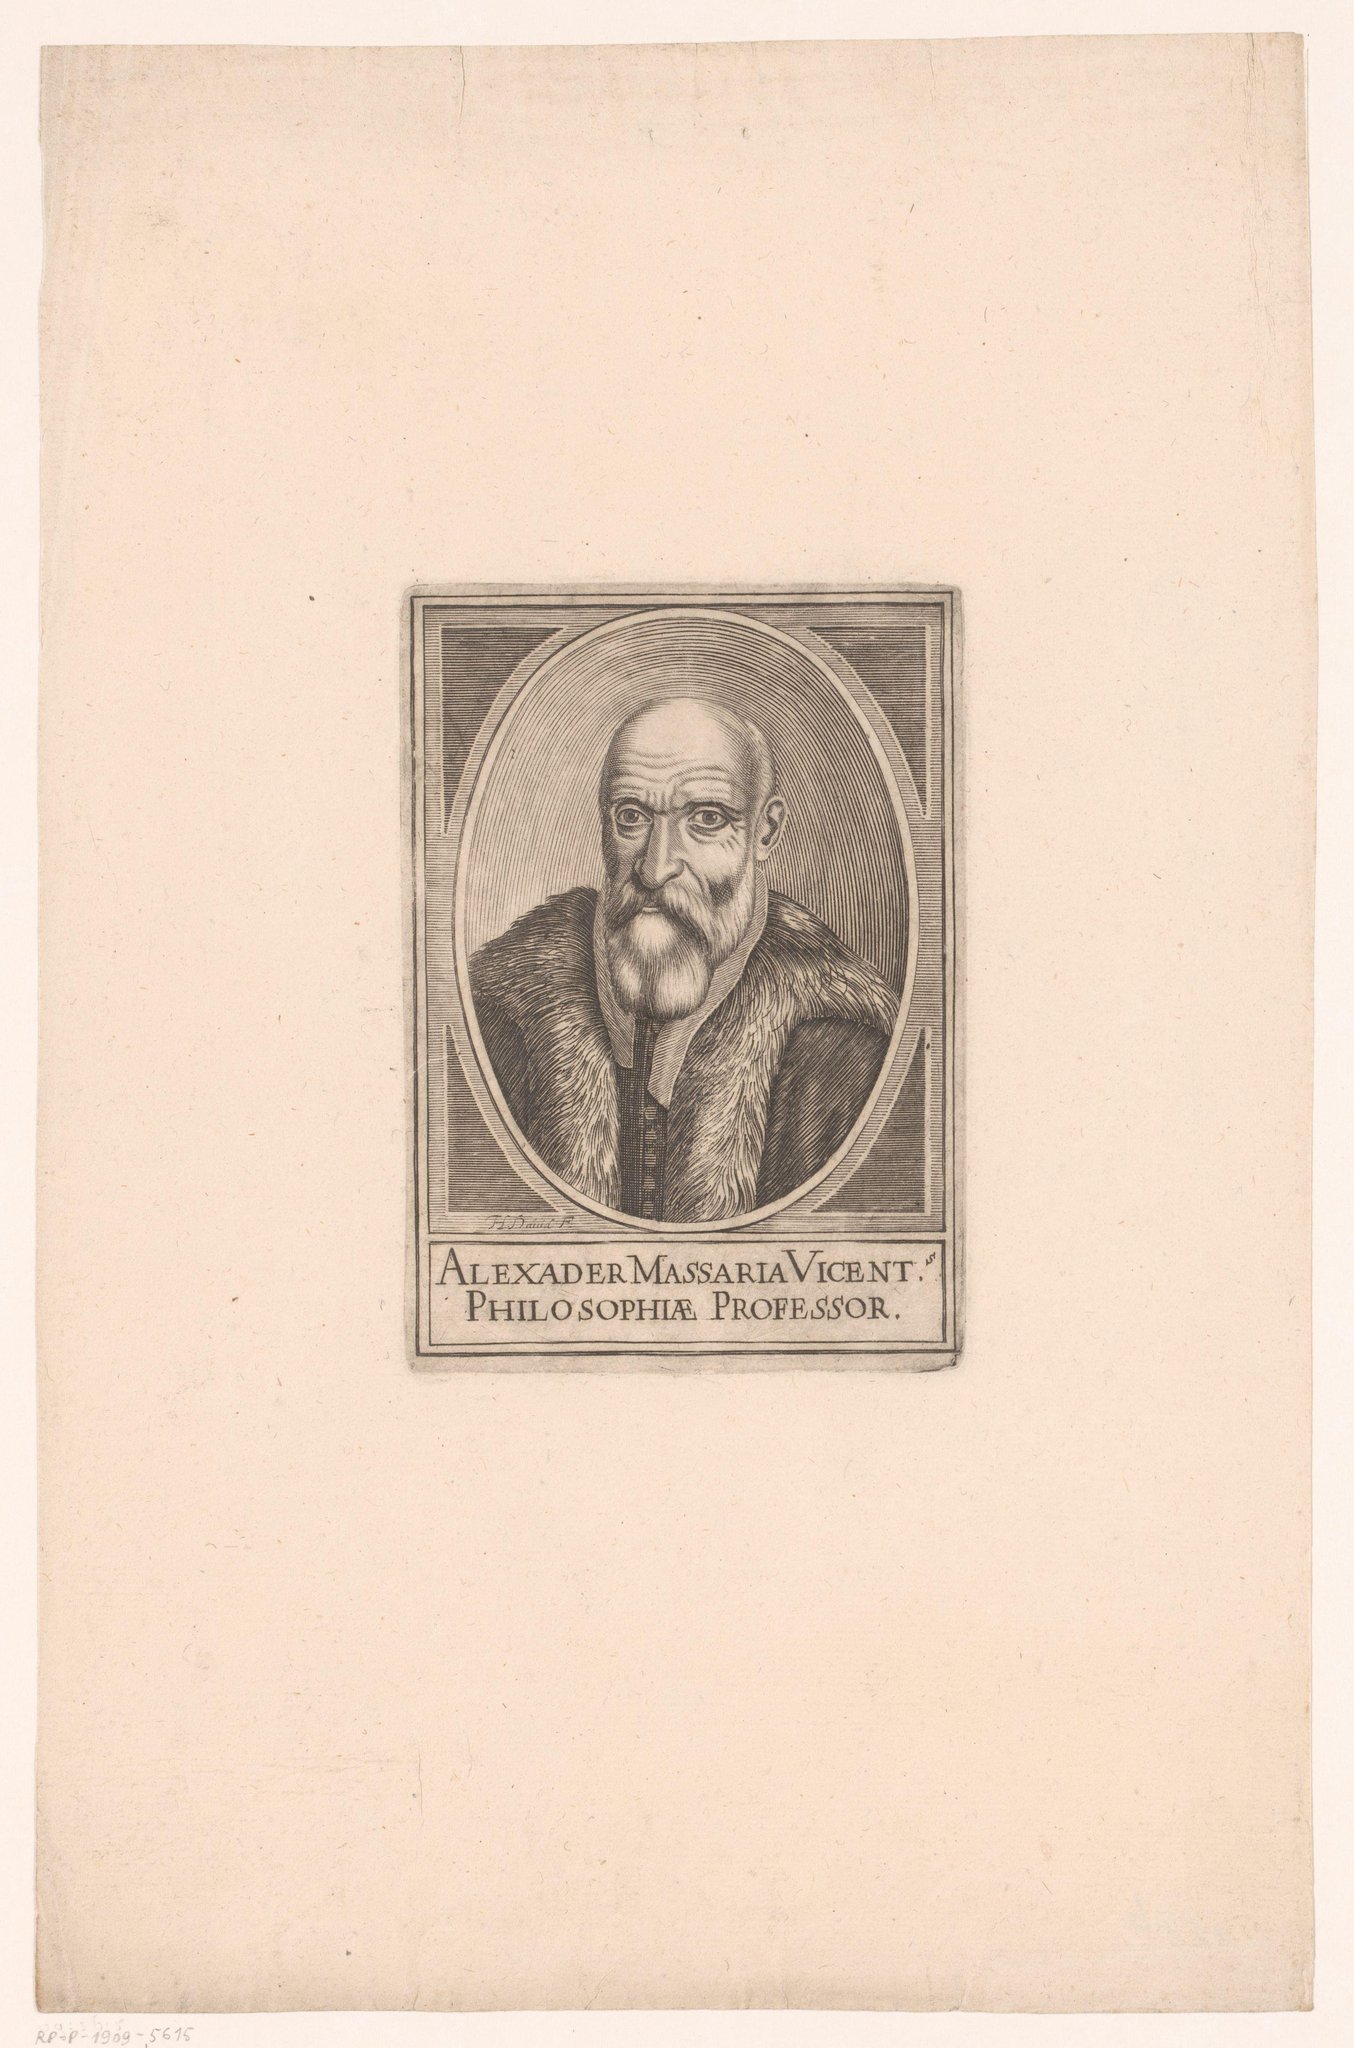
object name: print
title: Alexander Massaria Vicent. s Philosophiae Professor.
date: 1630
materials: paper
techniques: engraving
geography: padua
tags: historical persons, physician, doctor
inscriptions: collector's mark: Lugt 2228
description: Prent uit: Tomasini, Jacopo Filippo. Jacobi Philippi Tomasini Patavini Illustrium Virorum Elogia Iconibus Exornata (...). Padua: Donato Pasquardi, 1630, p. 165.